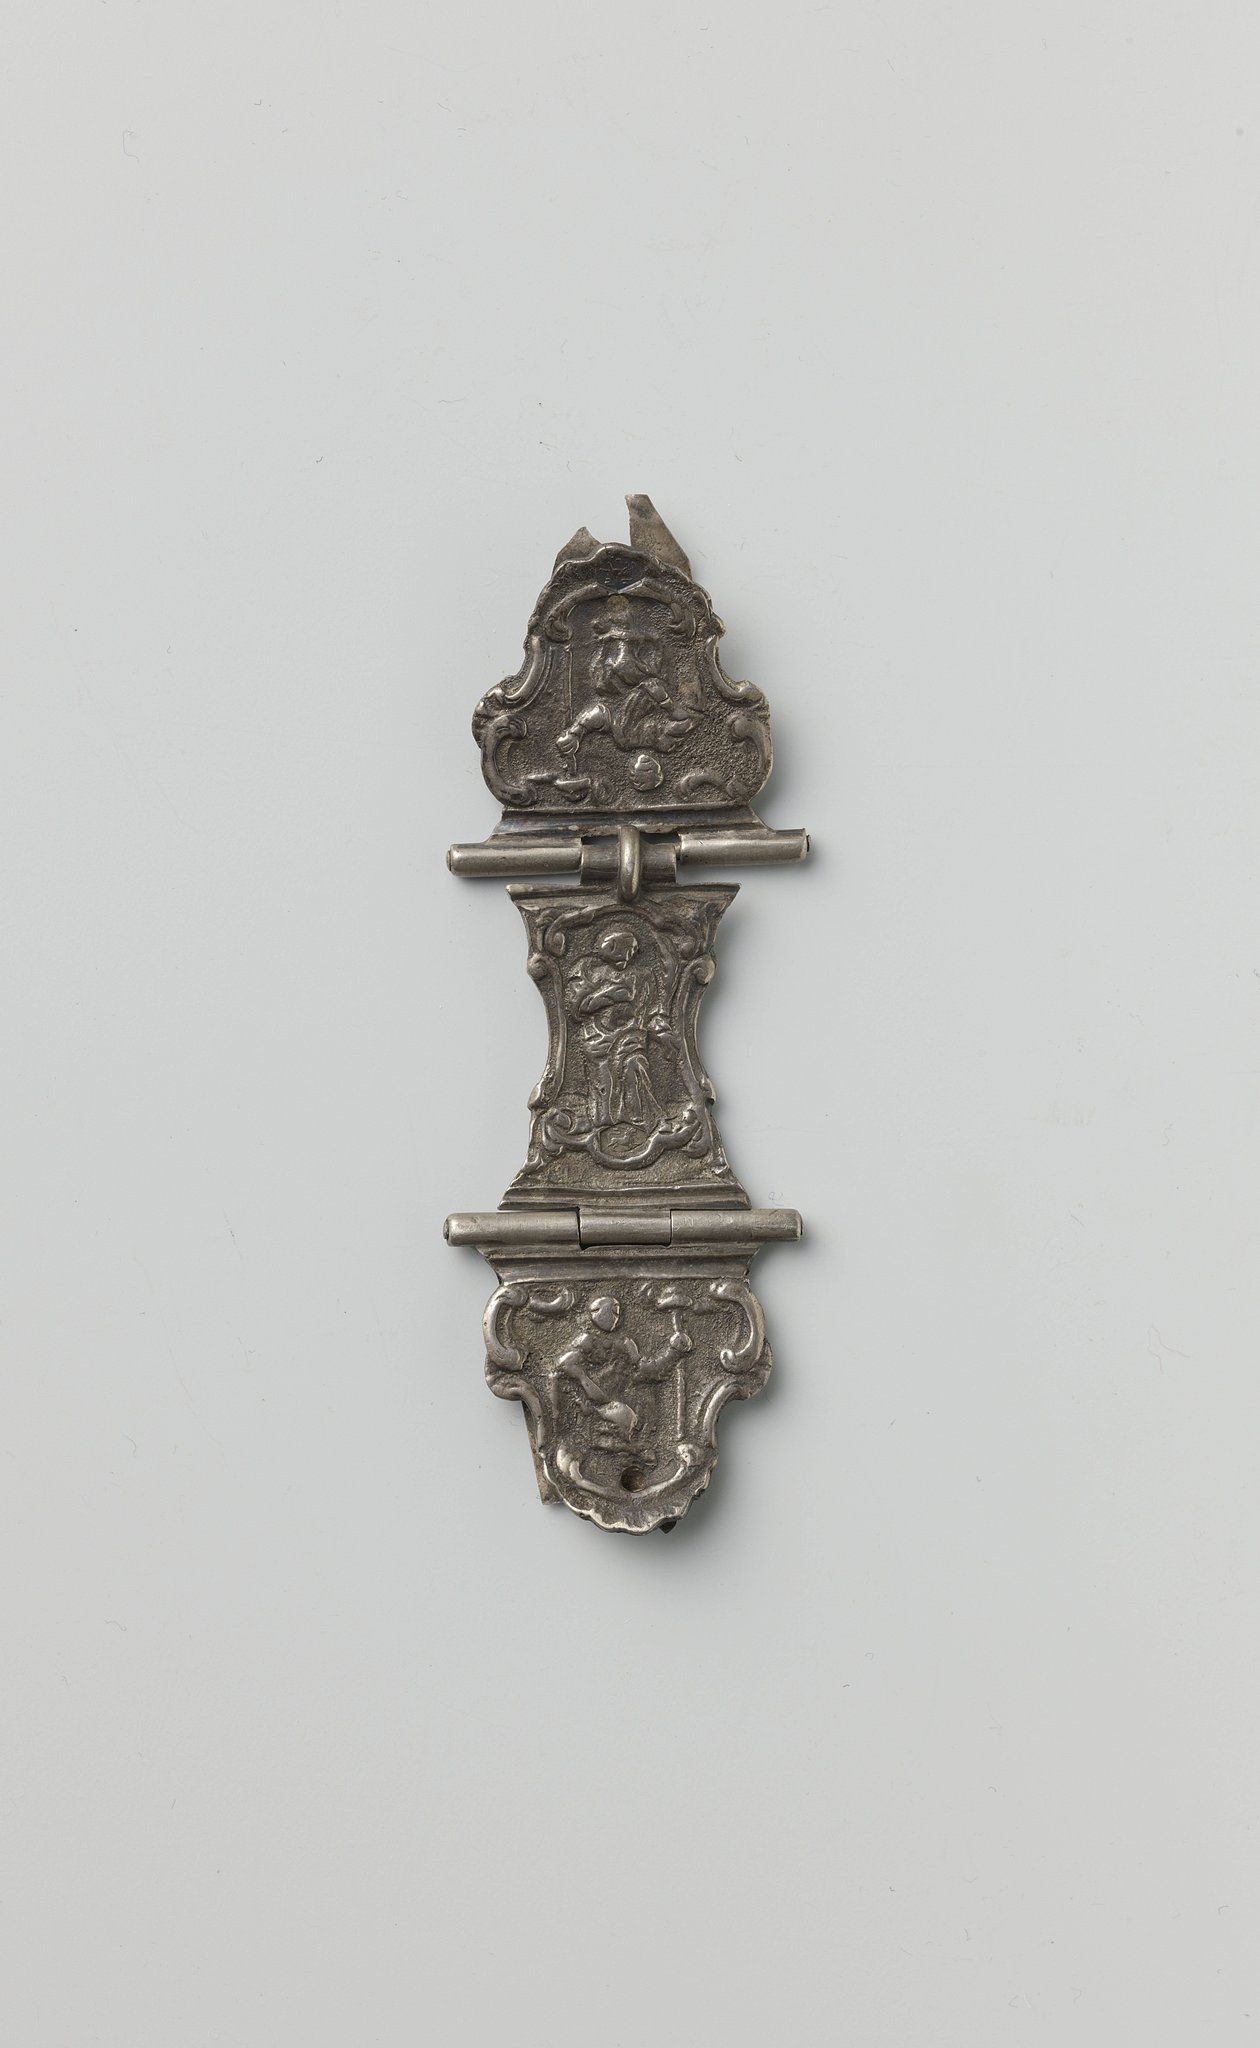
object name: boekslot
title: Boekslot met afbeelding van de Overwinning of de Faam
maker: willem nicolaas ernens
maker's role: silversmith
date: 1814-1827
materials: silver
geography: hoorn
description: Kerkboekslot van zilver. In het midden een afbeelding van de Overwinning of de Faam. Op de einden de vrijheid.